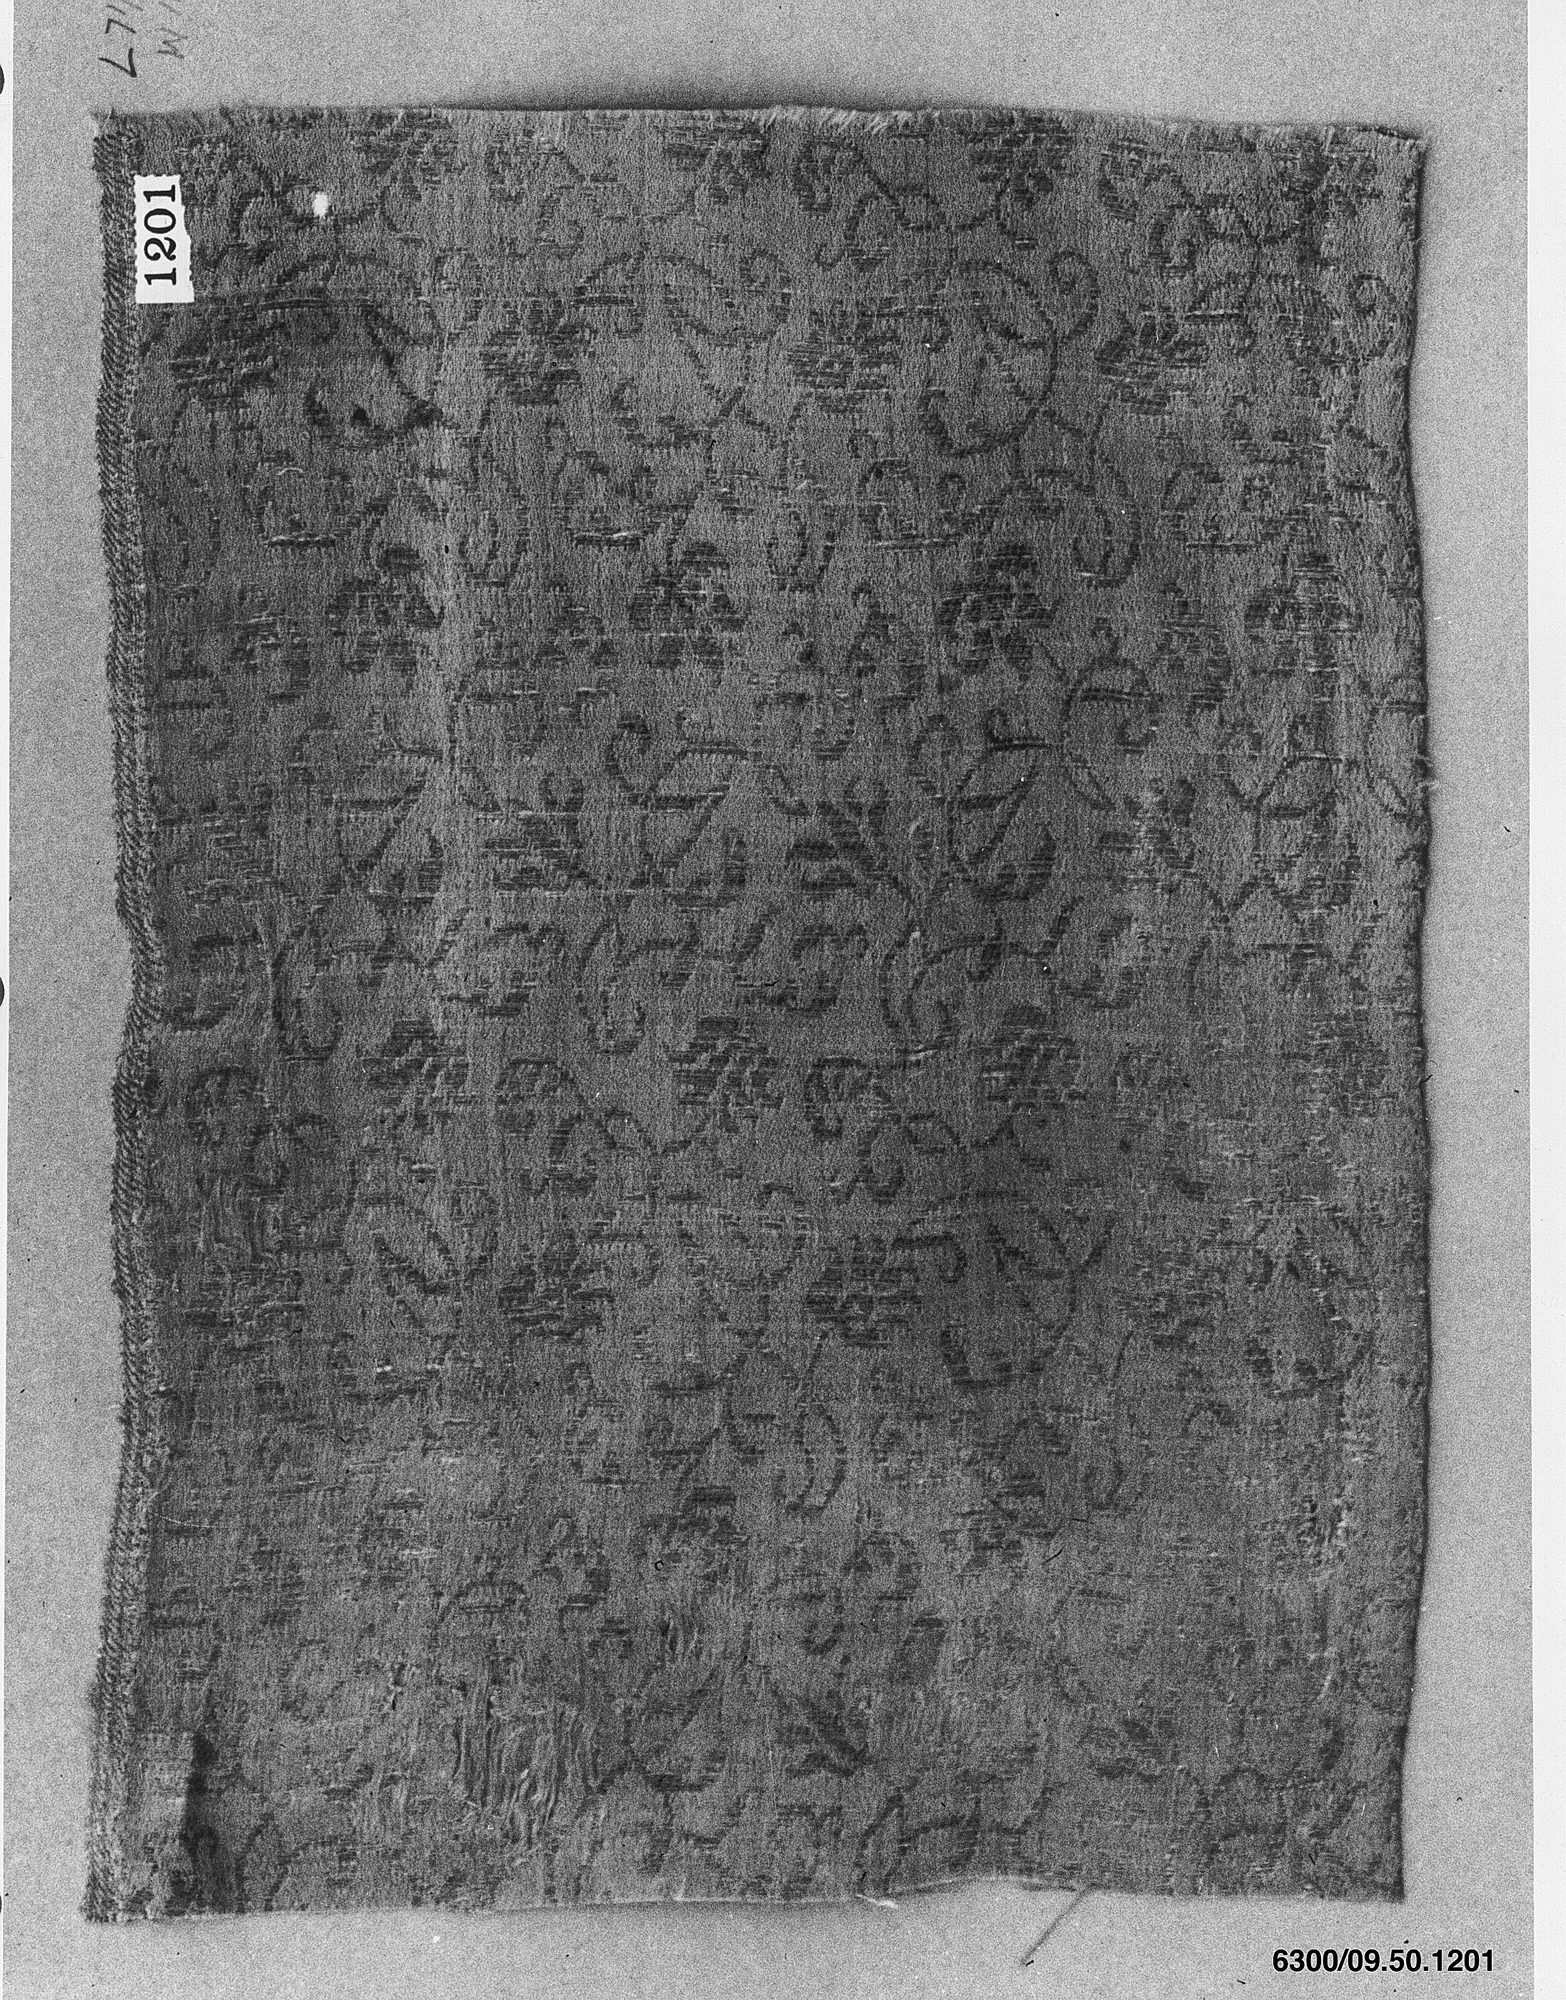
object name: piece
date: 1601-1800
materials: silk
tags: flowers,leaves